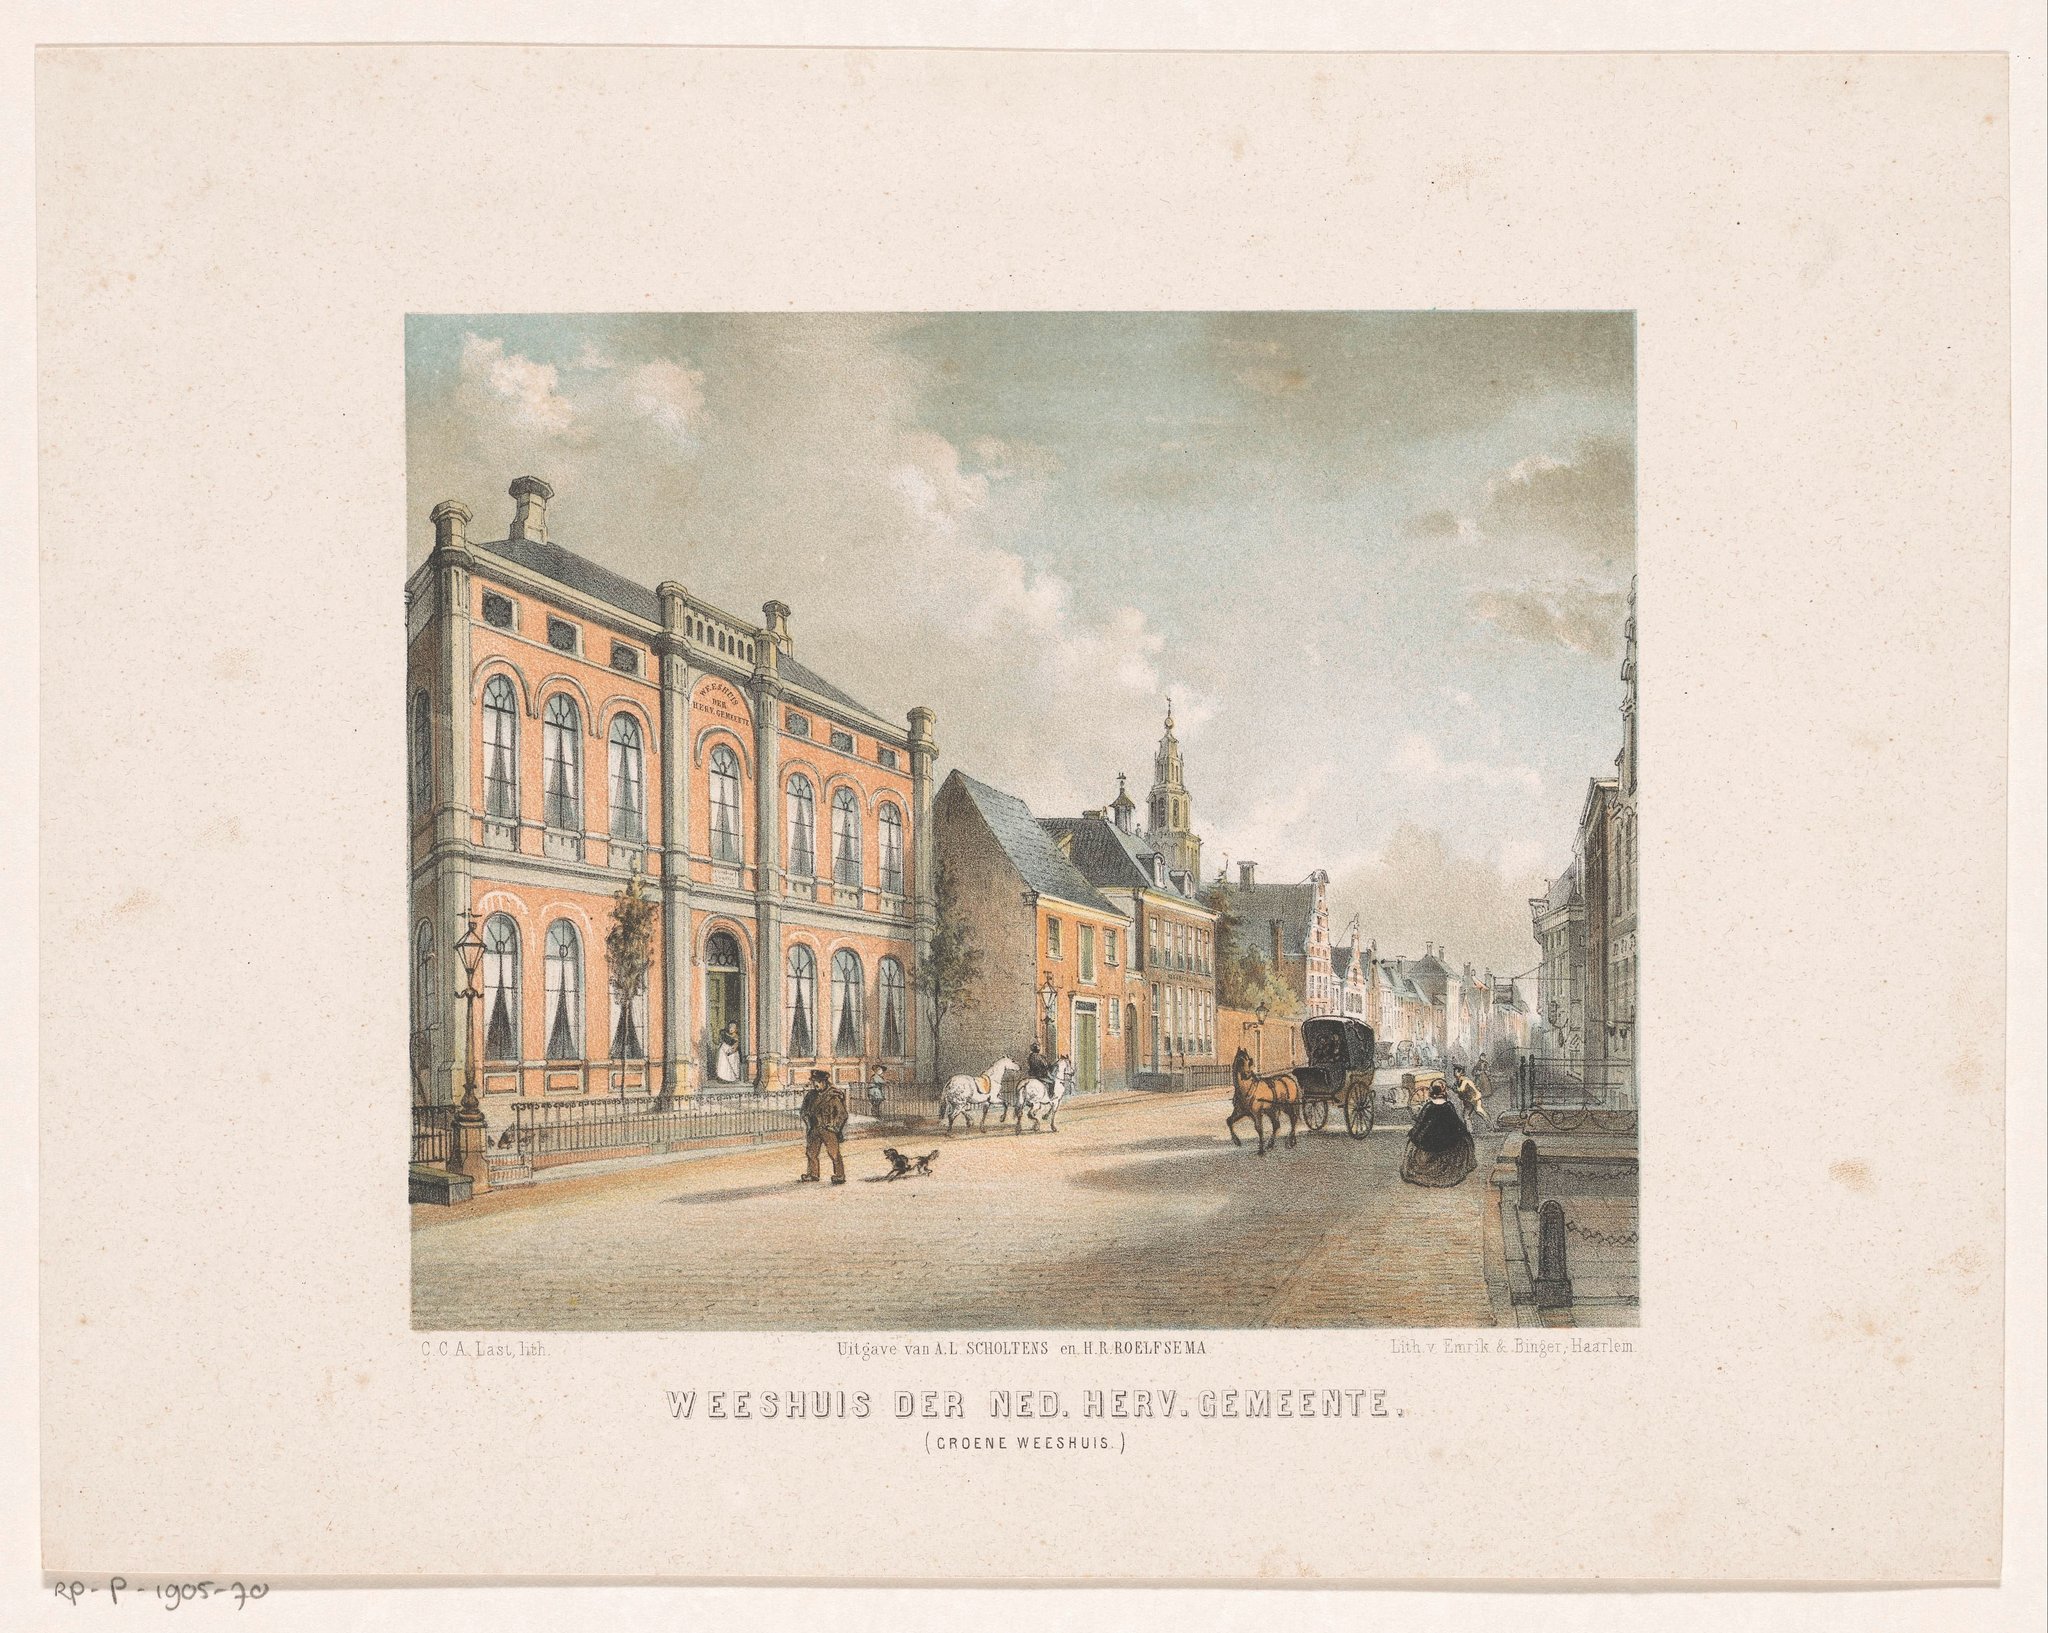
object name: print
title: Weeshuis der Ned. Herv. Gemeente (Groene weeshuis)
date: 1857-1869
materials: paper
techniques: lithograph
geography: groningen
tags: orphanage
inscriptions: collector's mark: Lugt 2228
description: Behoort tot een serie van, in ieder geval, twaalf prenten over Groningen. Zie RP-P-1905-63 t/m RP-P-1905-74.